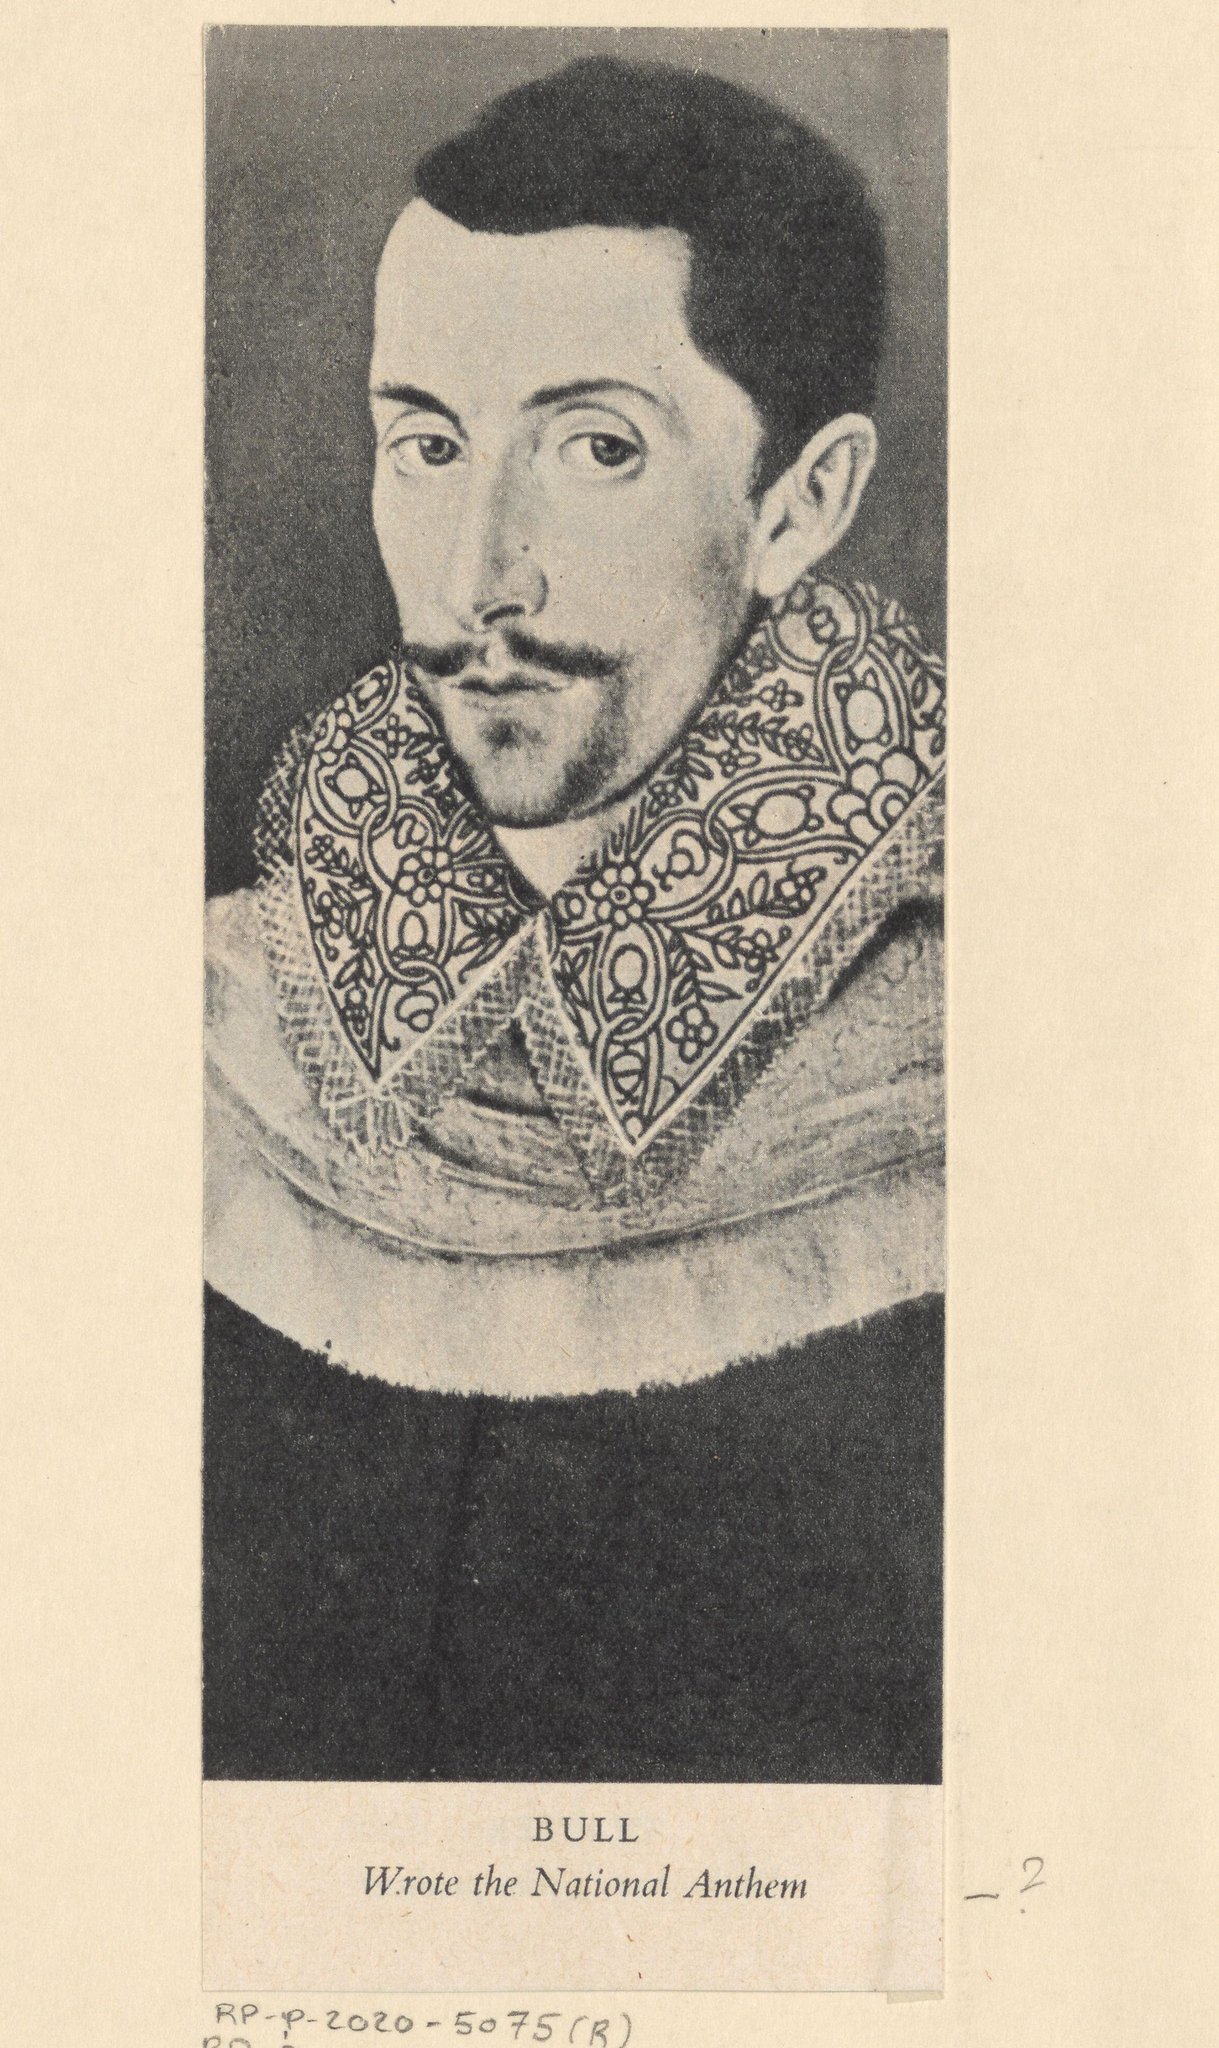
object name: photomechanical print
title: Portret van John Bull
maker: Anonymous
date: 1940-1950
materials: paper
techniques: rotogravure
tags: historical persons, portrait of composer